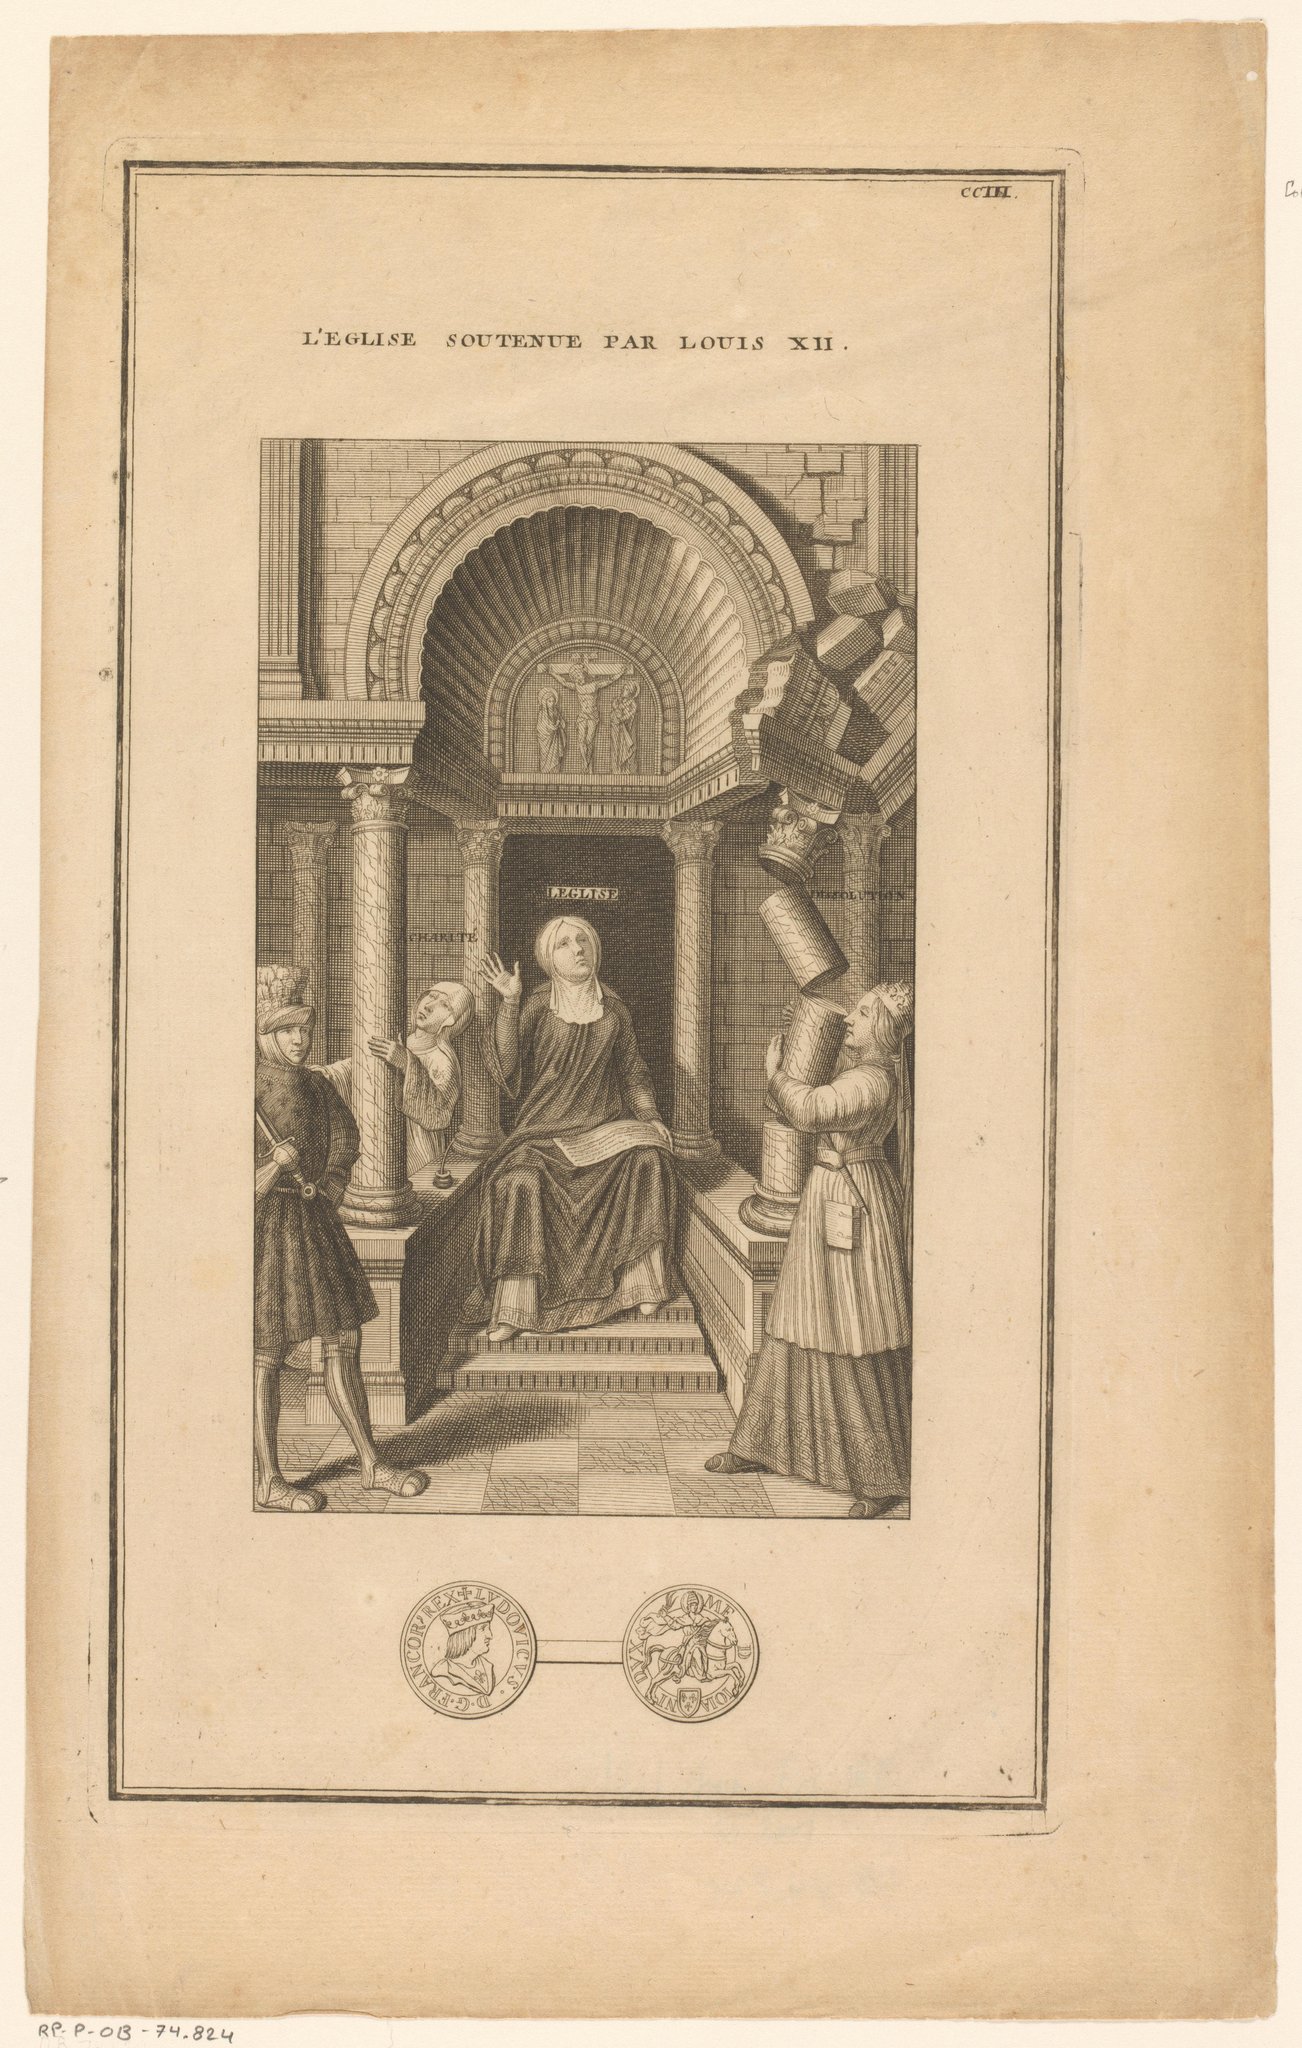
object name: book illustration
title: Personificatie van de kerk met Lodewijk XII, koning van Frankrijk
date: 1750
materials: paper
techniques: etching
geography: london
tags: charity, 'caritas'; 'carità' (ripa) ~ one of the three theological virtues, destruction, historical persons, the church personified, 'ecclesia', usually with chalice and banner, coin, king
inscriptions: collector's mark: Lugt 2228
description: Prent uit: Montfaucon, Bernard de. A collection of regal and ecclesiastical antiquities of France (...). Londen: William Innys, John en Paul Knapton, R. Manby en Henry Shute Cox, 1750, dl. 2. Prent voor het eerst, met andere nummering, verschenen in: Montfaucon, Bernard de. Les monumens de la Monarchie Françoise (...). Parijs: Julien-Michel Gandouin en Pierre-François Giffart, 1729-1733.